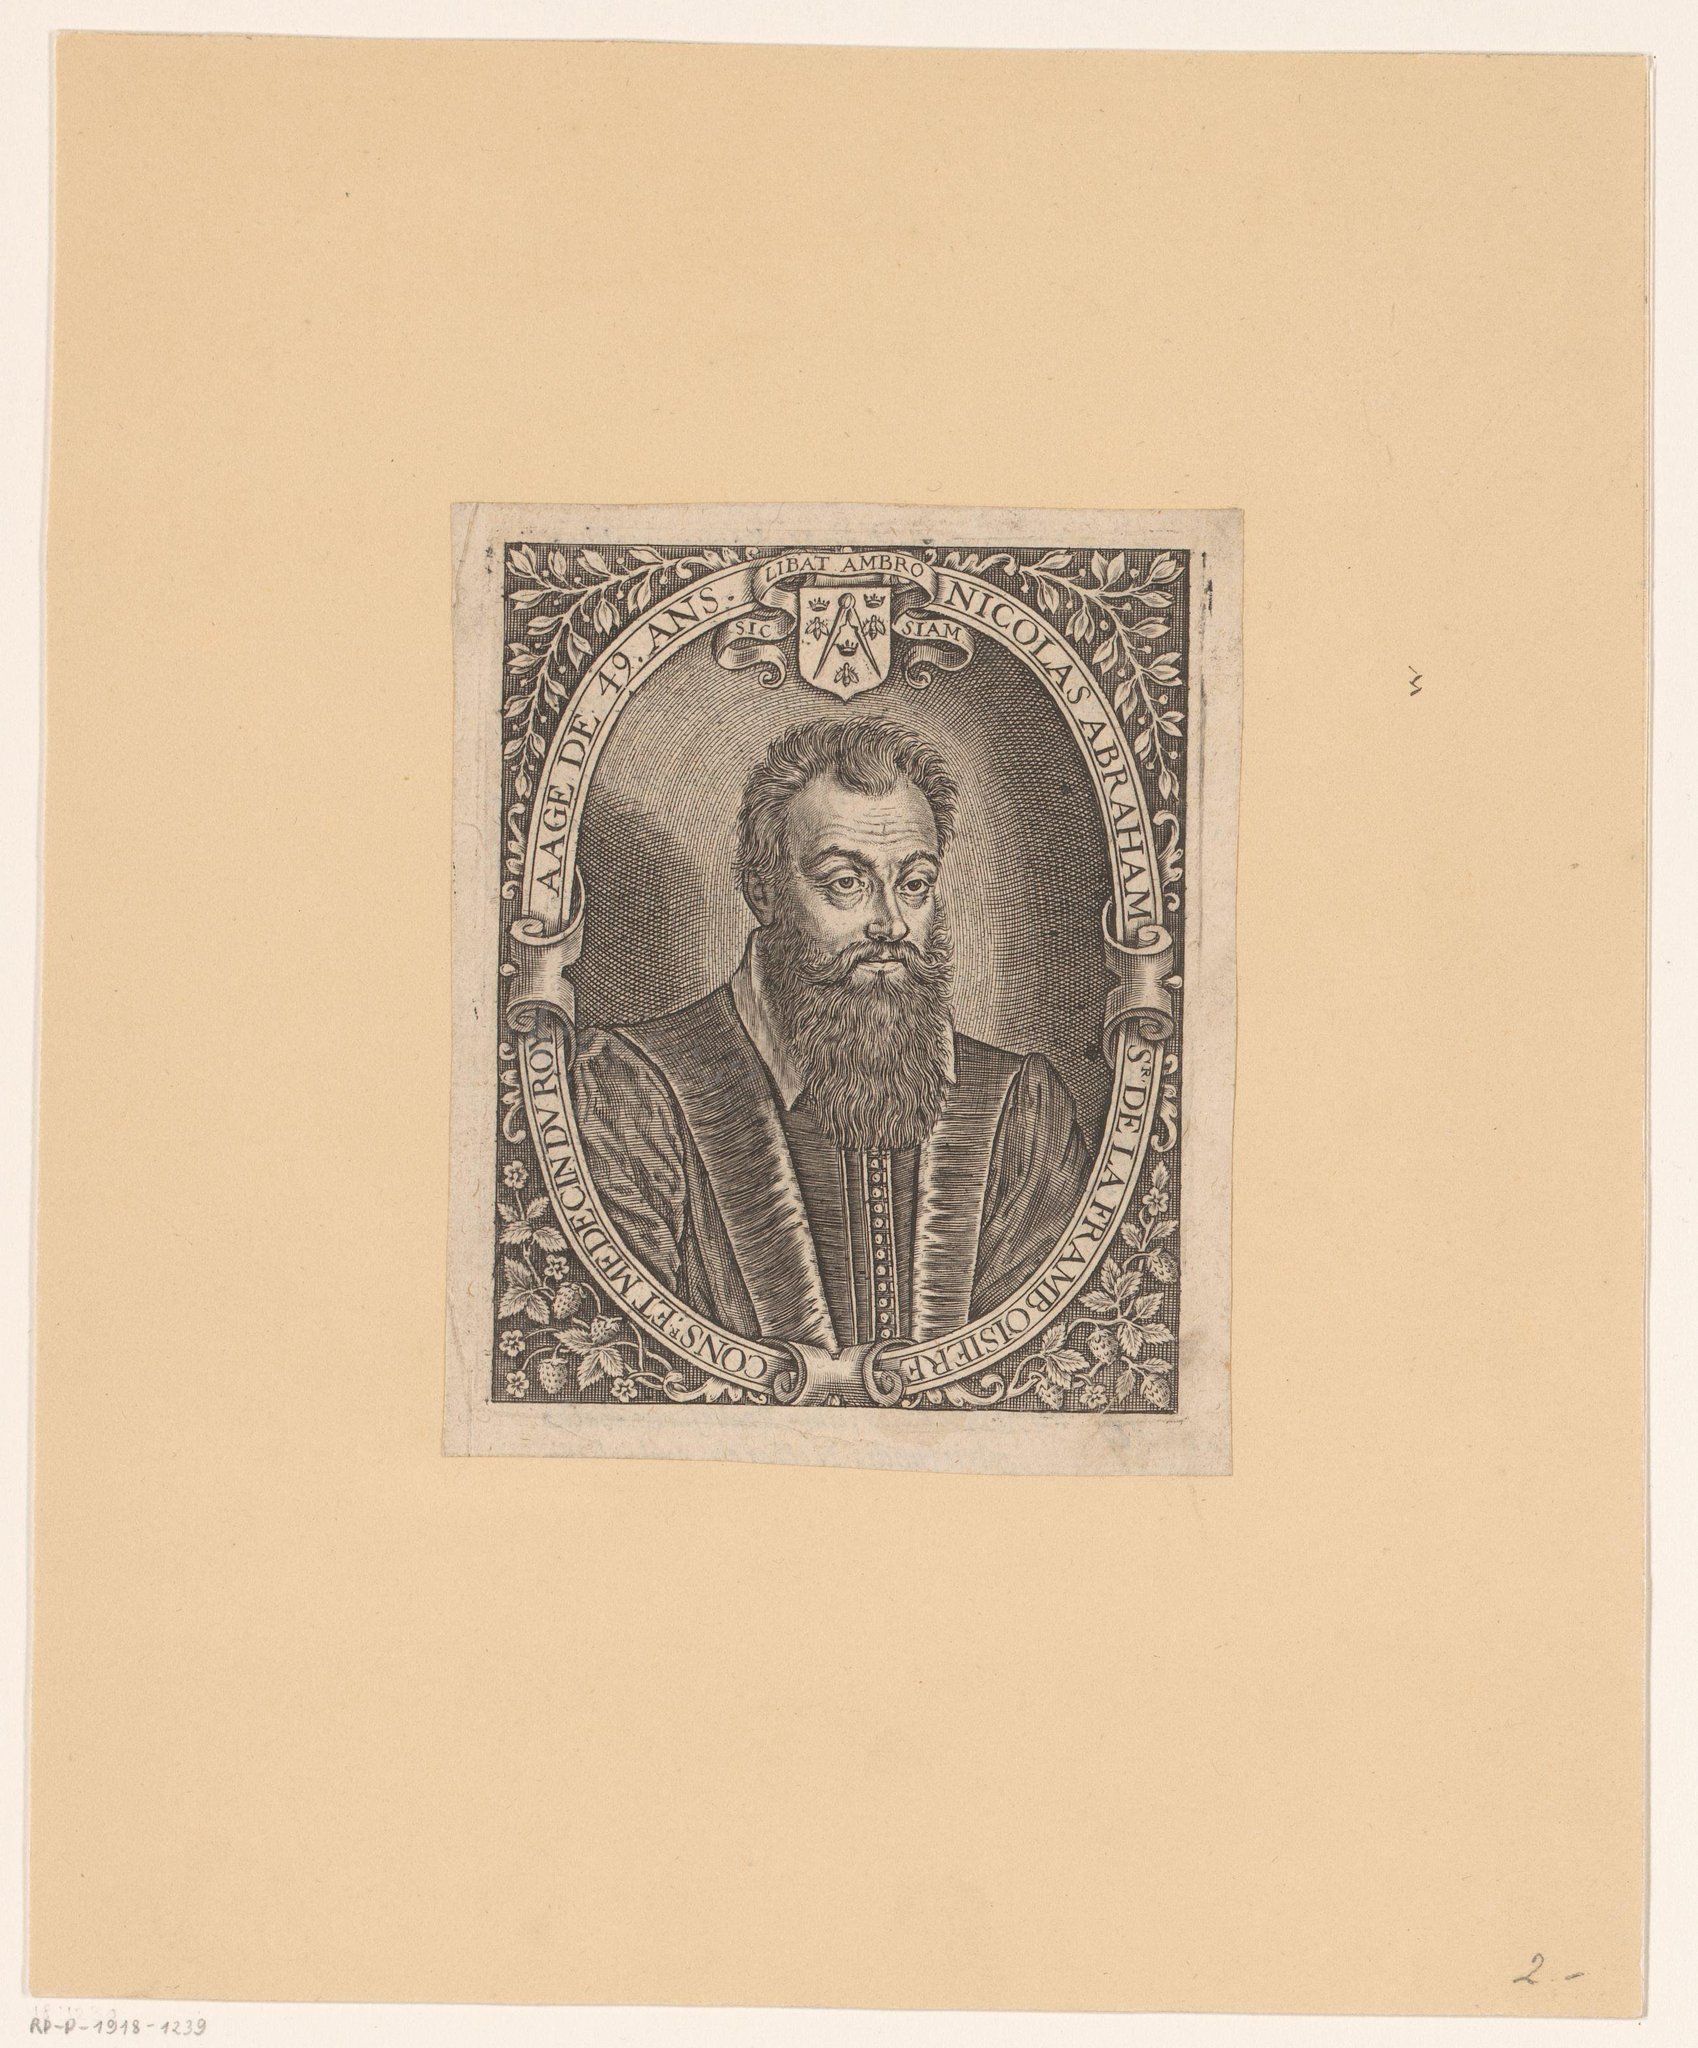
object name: book illustration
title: Portret van Nicolas Abraham de La Framboisière op 49-jarige leeftijd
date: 1619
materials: paper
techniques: engraving, letterpress printing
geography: paris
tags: fruits: raspberry, ornament ~ medallion, historical persons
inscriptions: collector's mark: Lugt 2233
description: Prent uit: Framboisière, Nicolas Abraham de la. Canones et consultationes medicinales, quibus recta medicinae (...). Parijs: Sonnium, Michaelem, 1619.